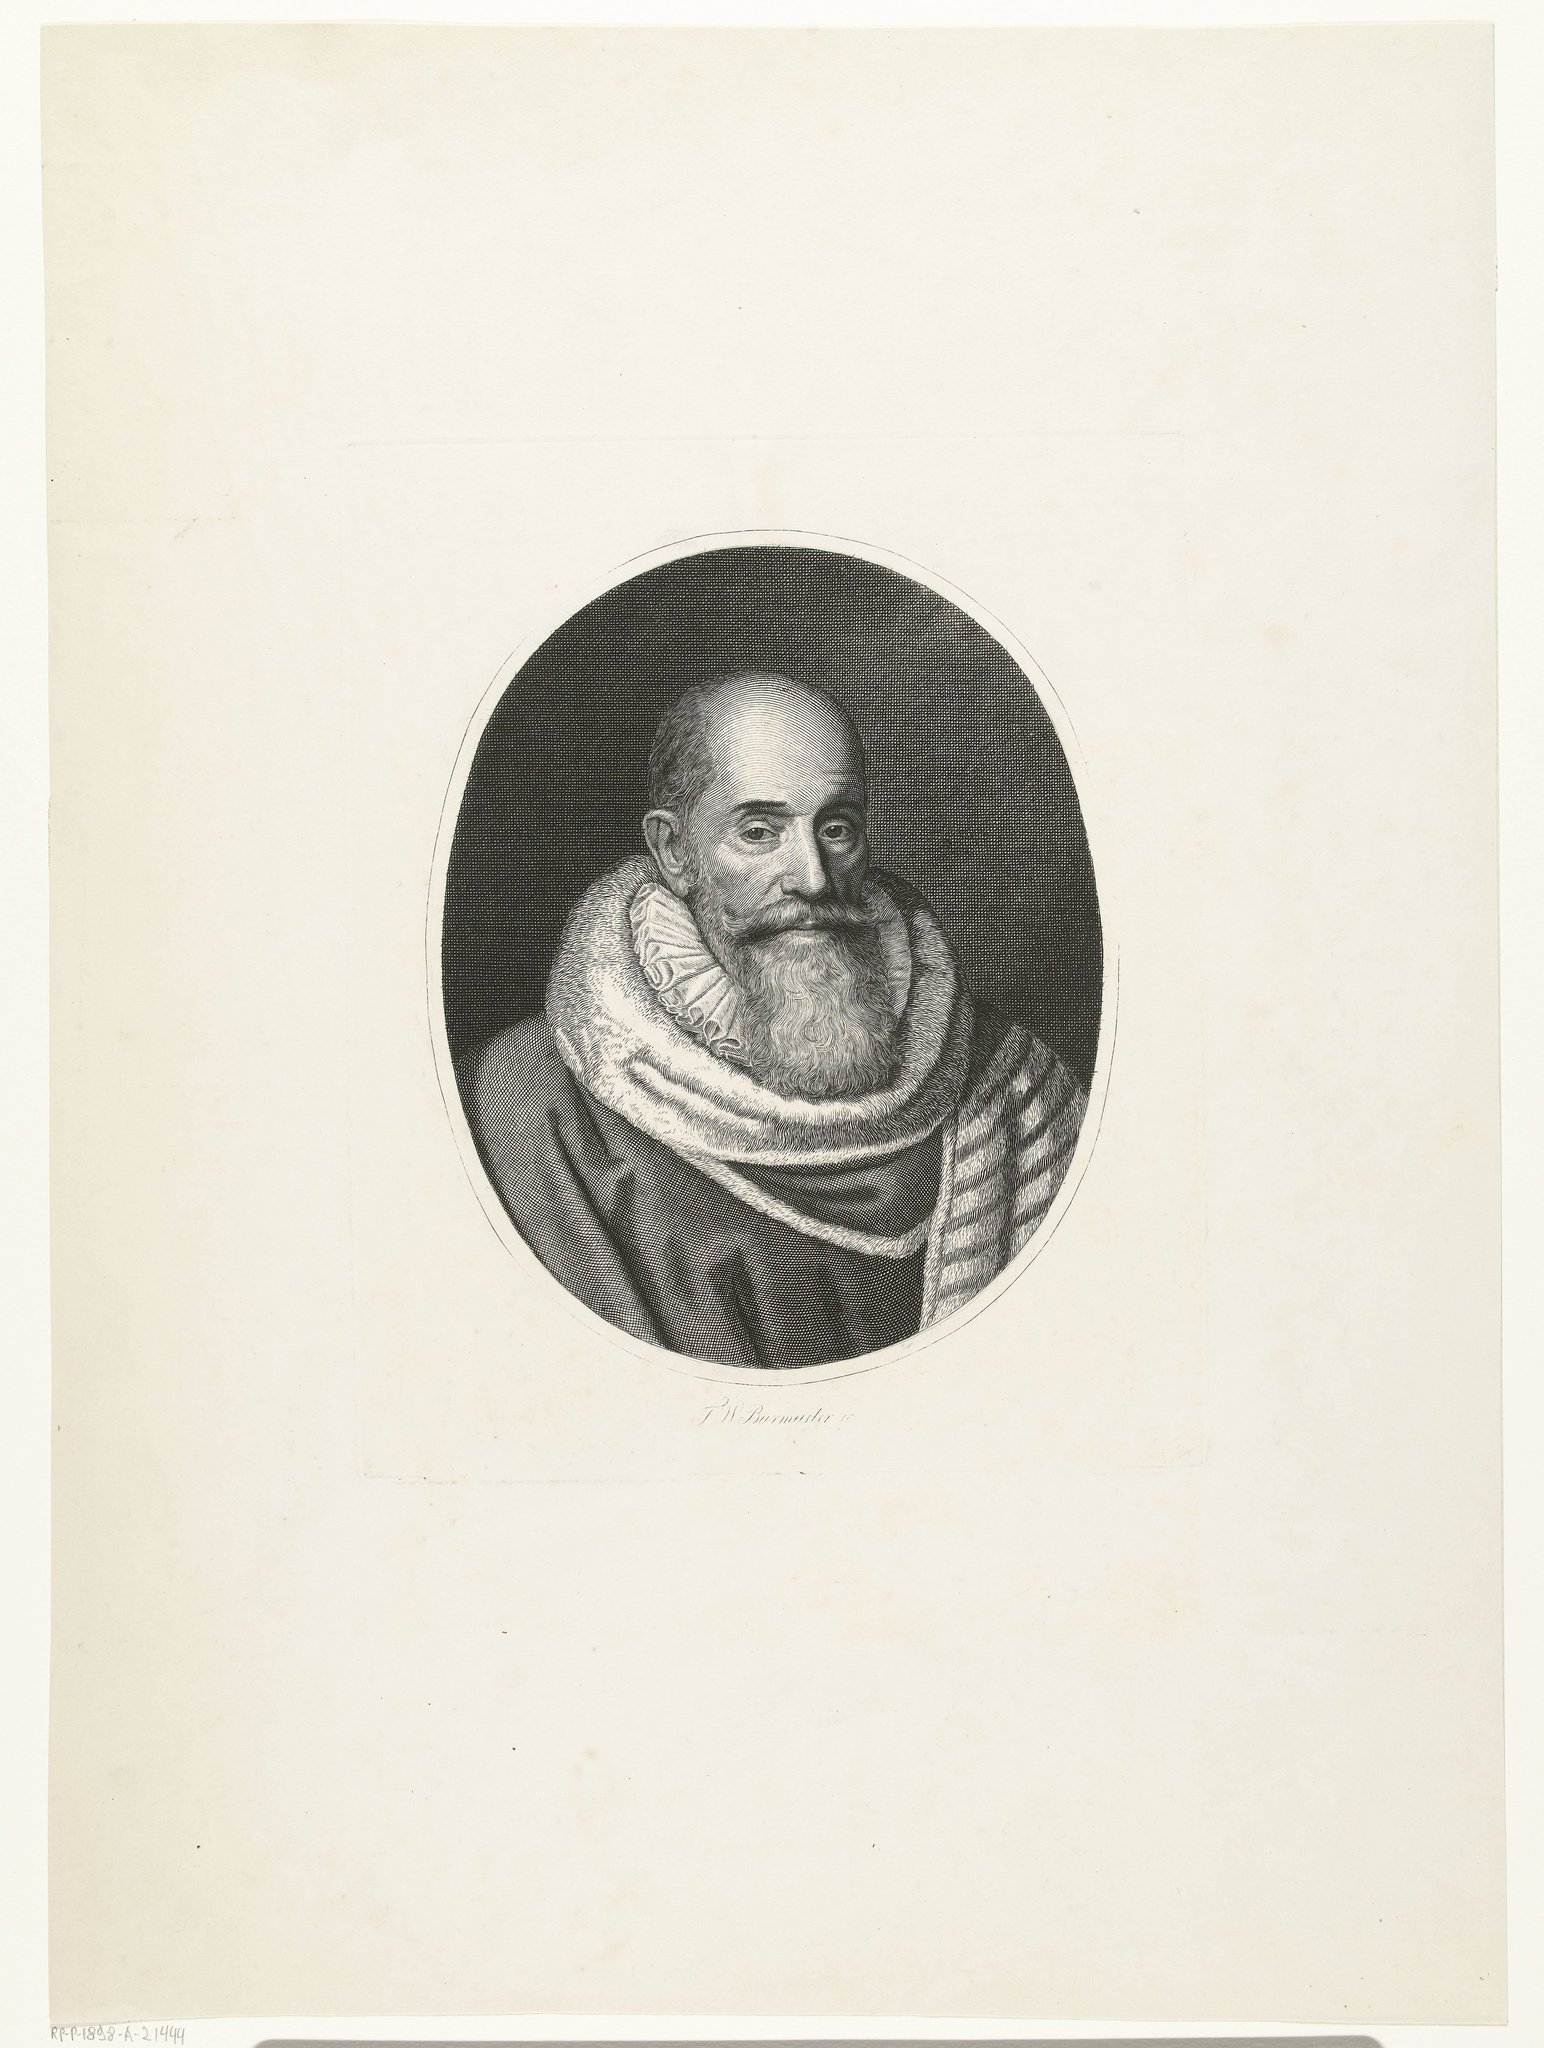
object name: print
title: Portret van een oude man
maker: friedrich wilhelm burmeister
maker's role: print maker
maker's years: 1845-1933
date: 1855-1915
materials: paper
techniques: engraving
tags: anonymous historical person portrayed alone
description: Portret in ovale lijst van een oude man. Hoofd licht naar rechts gekeerd. Hij heeft een mantel aan van bont en draagt een kraag rond de hals.